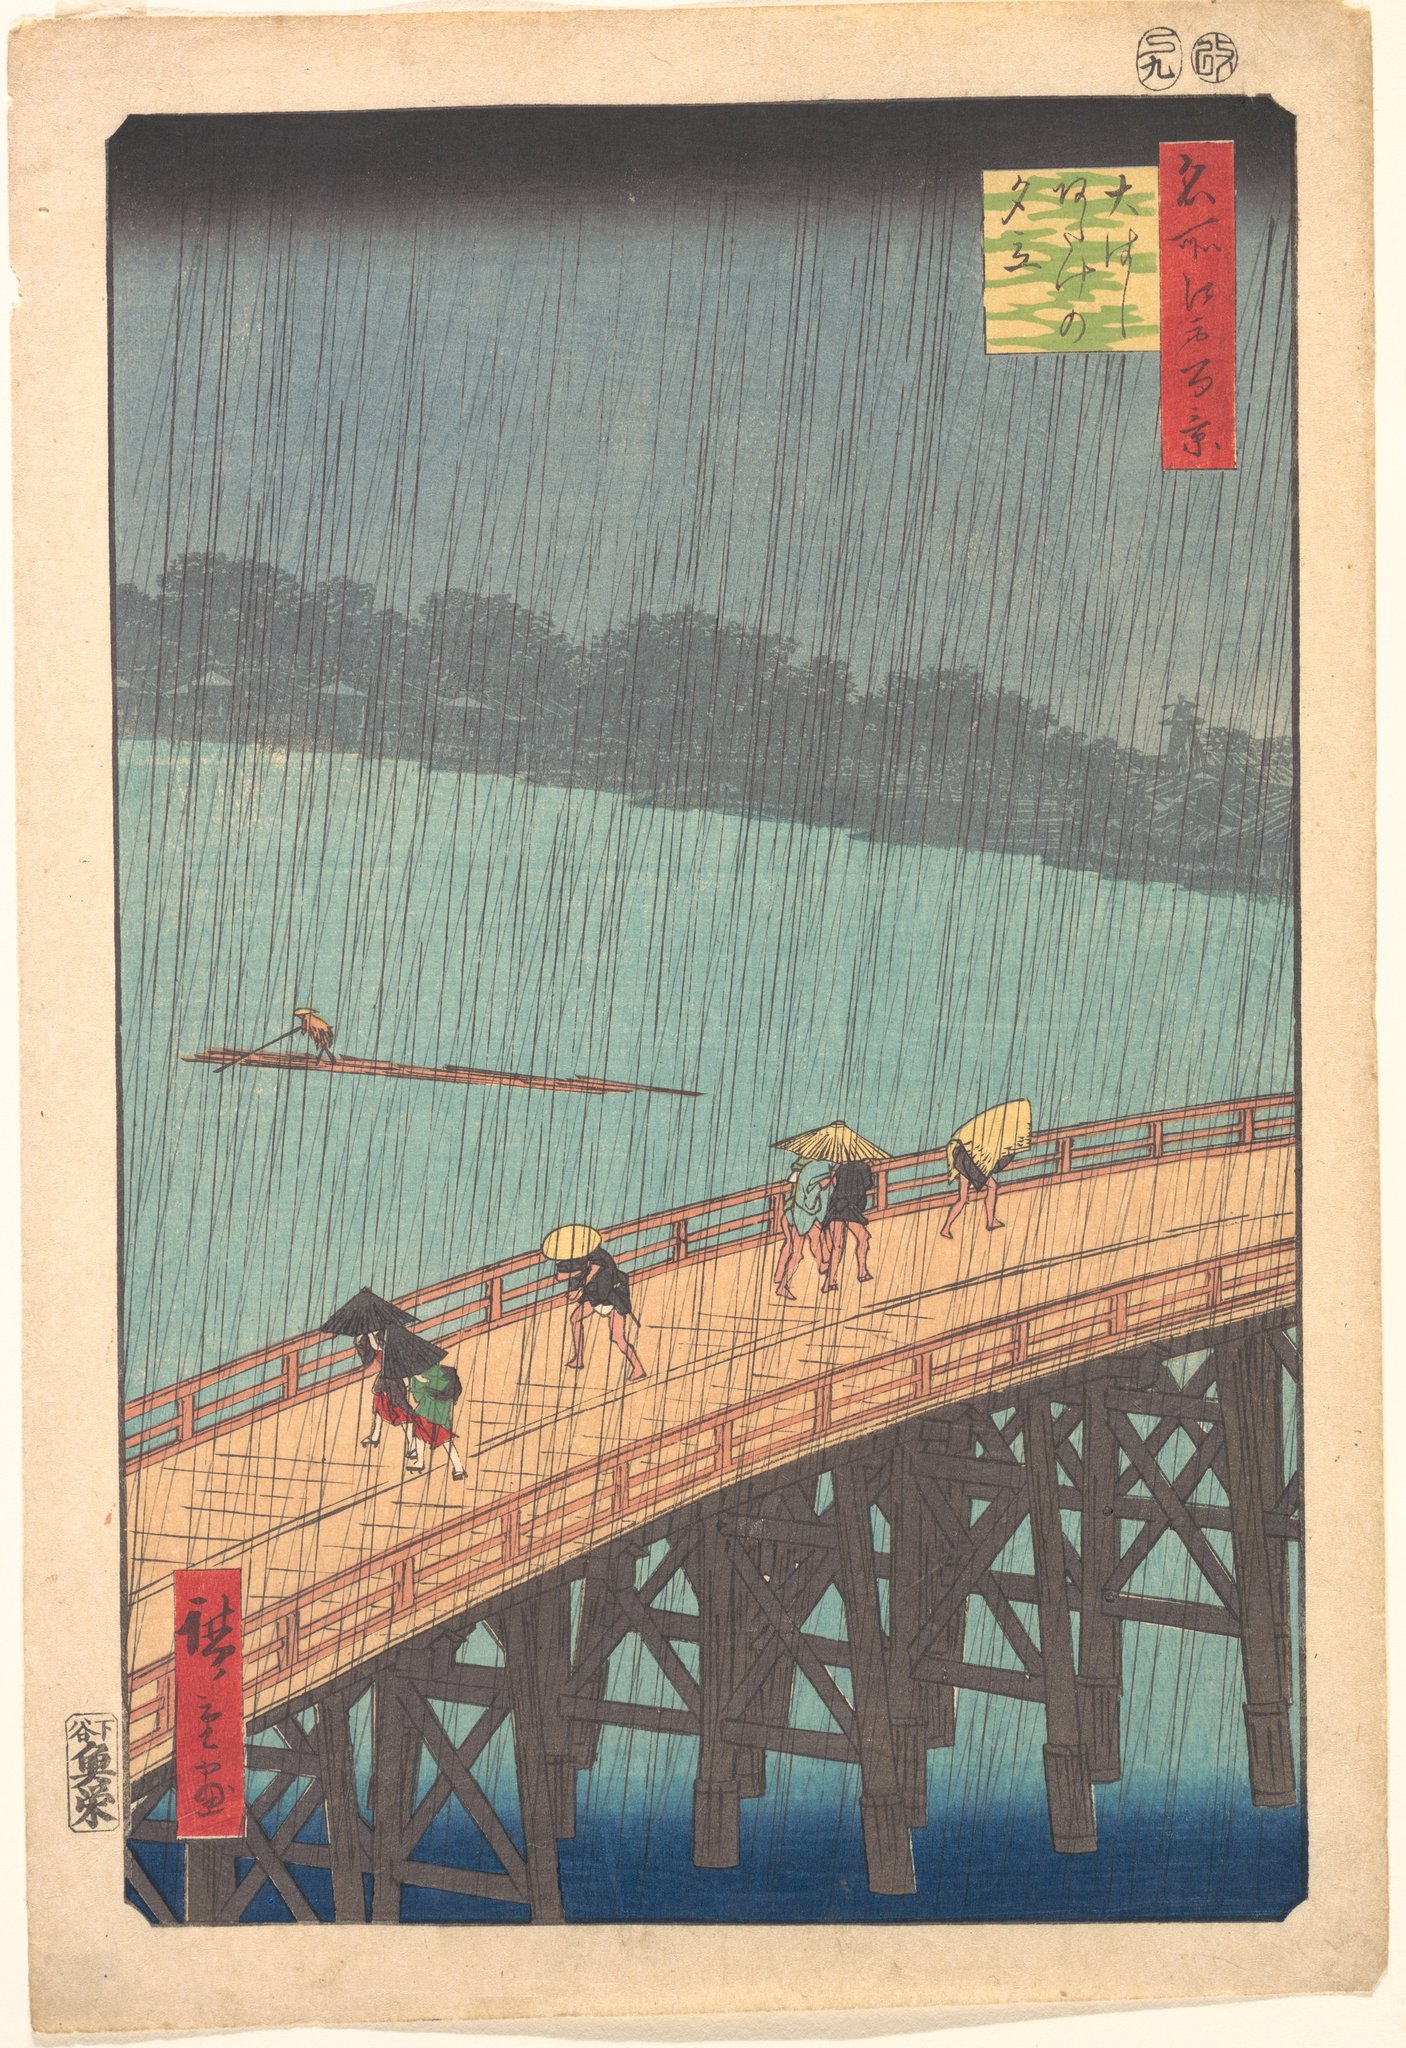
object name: print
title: Sudden Shower over Shin-Ōhashi Bridge and Atake (Ōhashi Atake no yūdachi), from the series One Hundred Famous Views of Edo (Meisho Edo hyakkei)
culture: japanese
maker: utagawa hiroshige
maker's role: artist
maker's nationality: japanese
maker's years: 1797-1858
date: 1857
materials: ink, paper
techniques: woodblock print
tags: bridges,rain,umbrellas